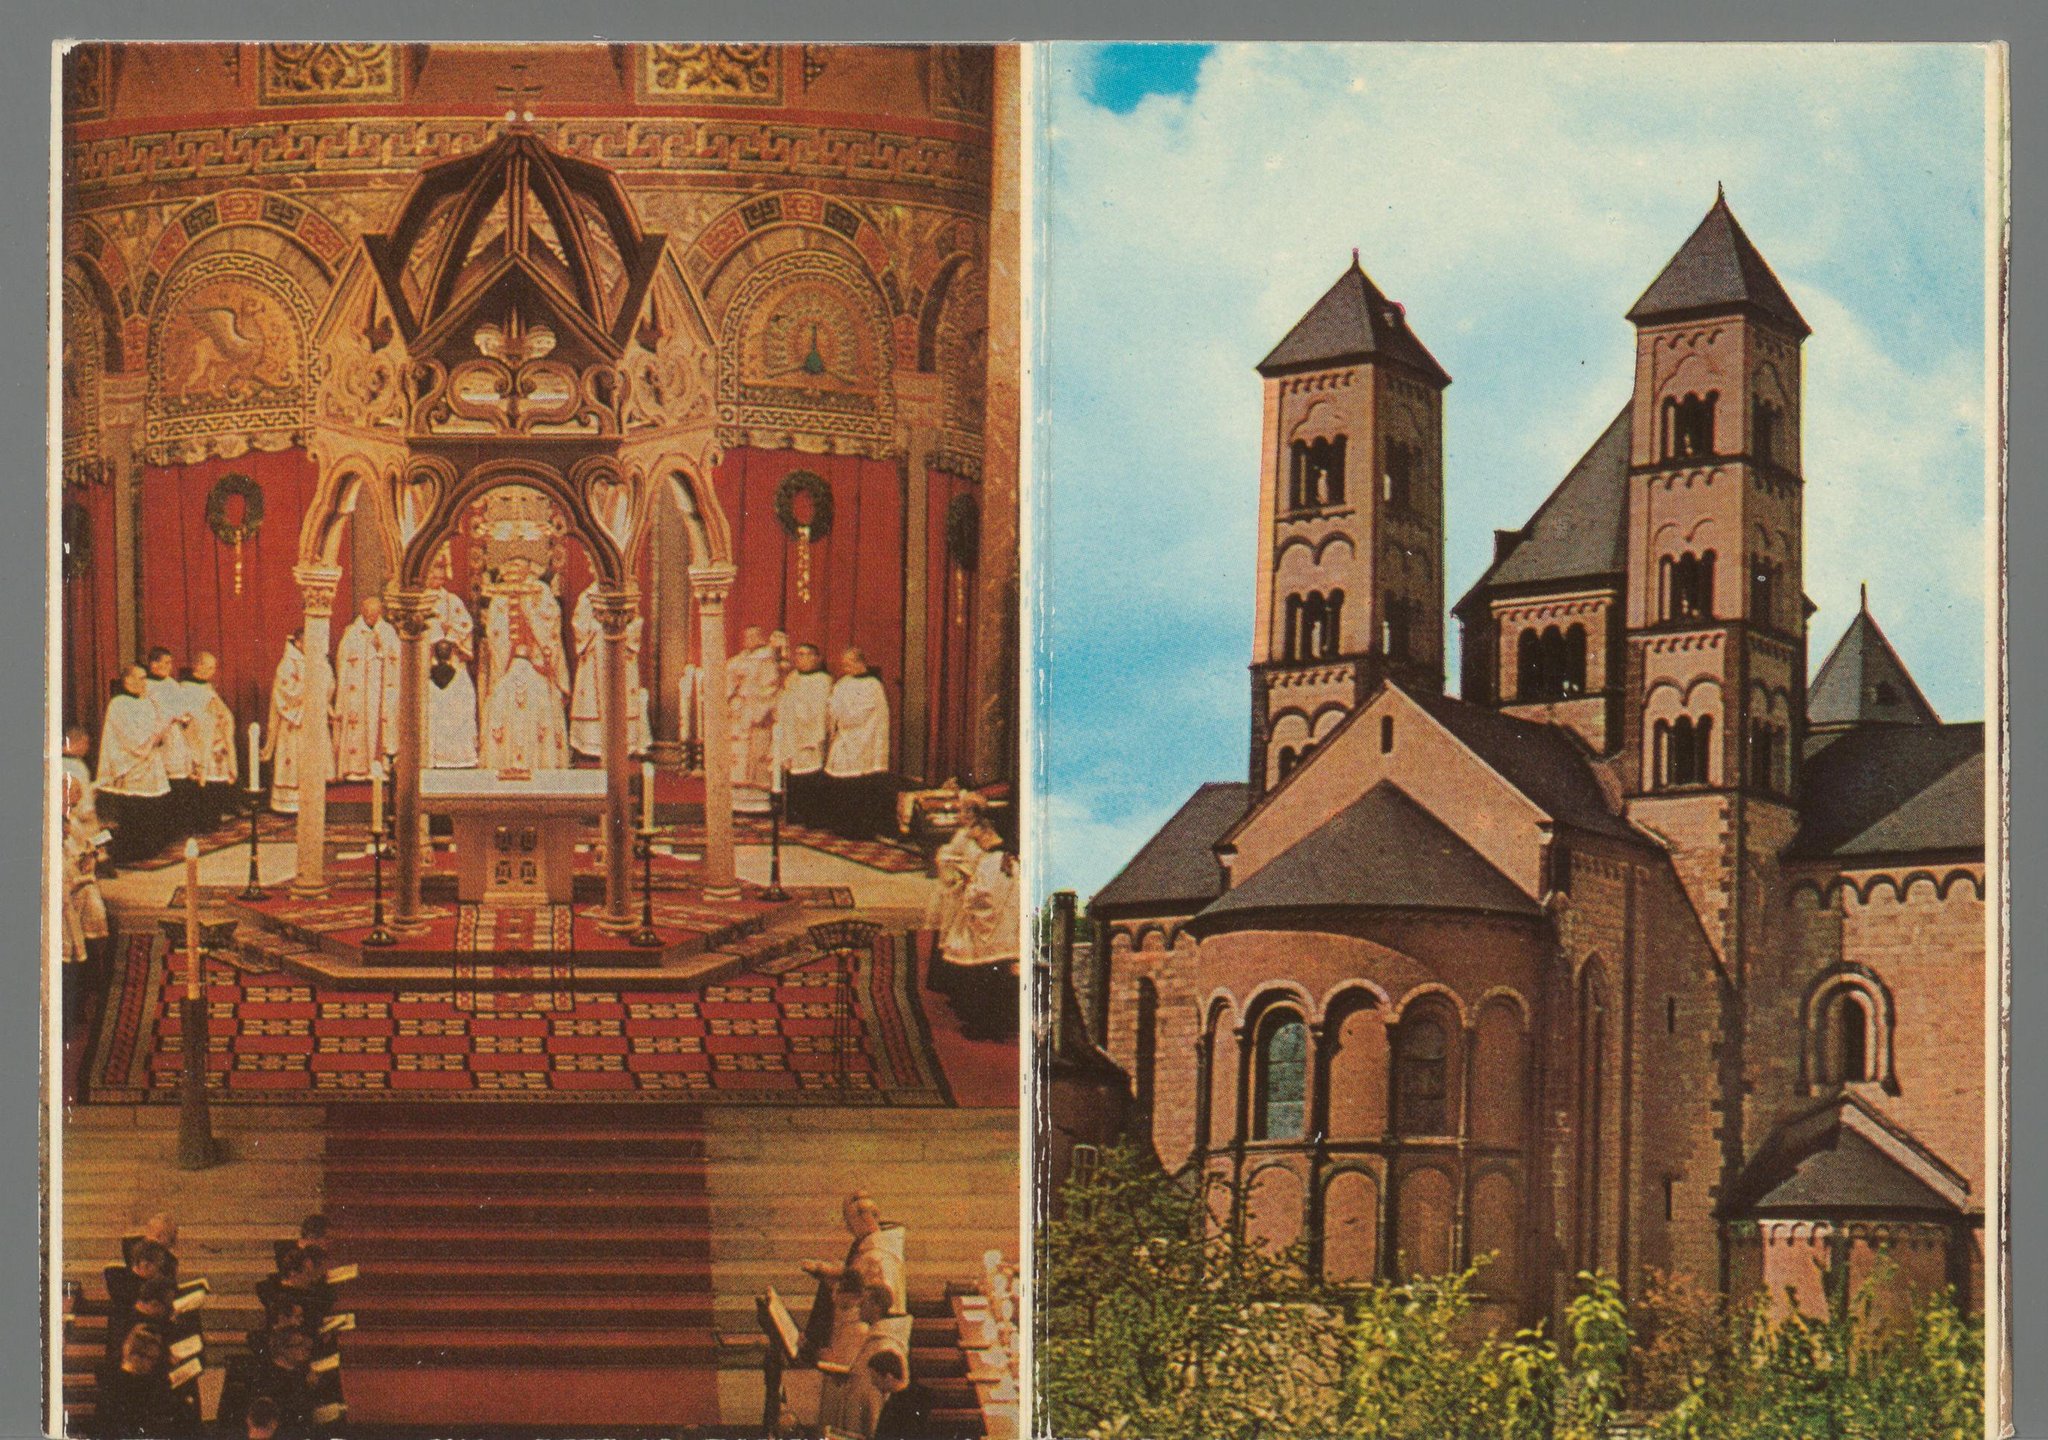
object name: ansichtkaart, prentbriefkaart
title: Hochaltar mit Pontifikalgottesdienst / Maître-autel / Pontifical service at high altar / Een pontificale mis aan het hoogaltaar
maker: Anonymous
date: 1960-1990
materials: cardboard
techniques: offset printed, writing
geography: eifel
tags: abbey, monastery, convent ~ roman catholic church, altar with altar-piece